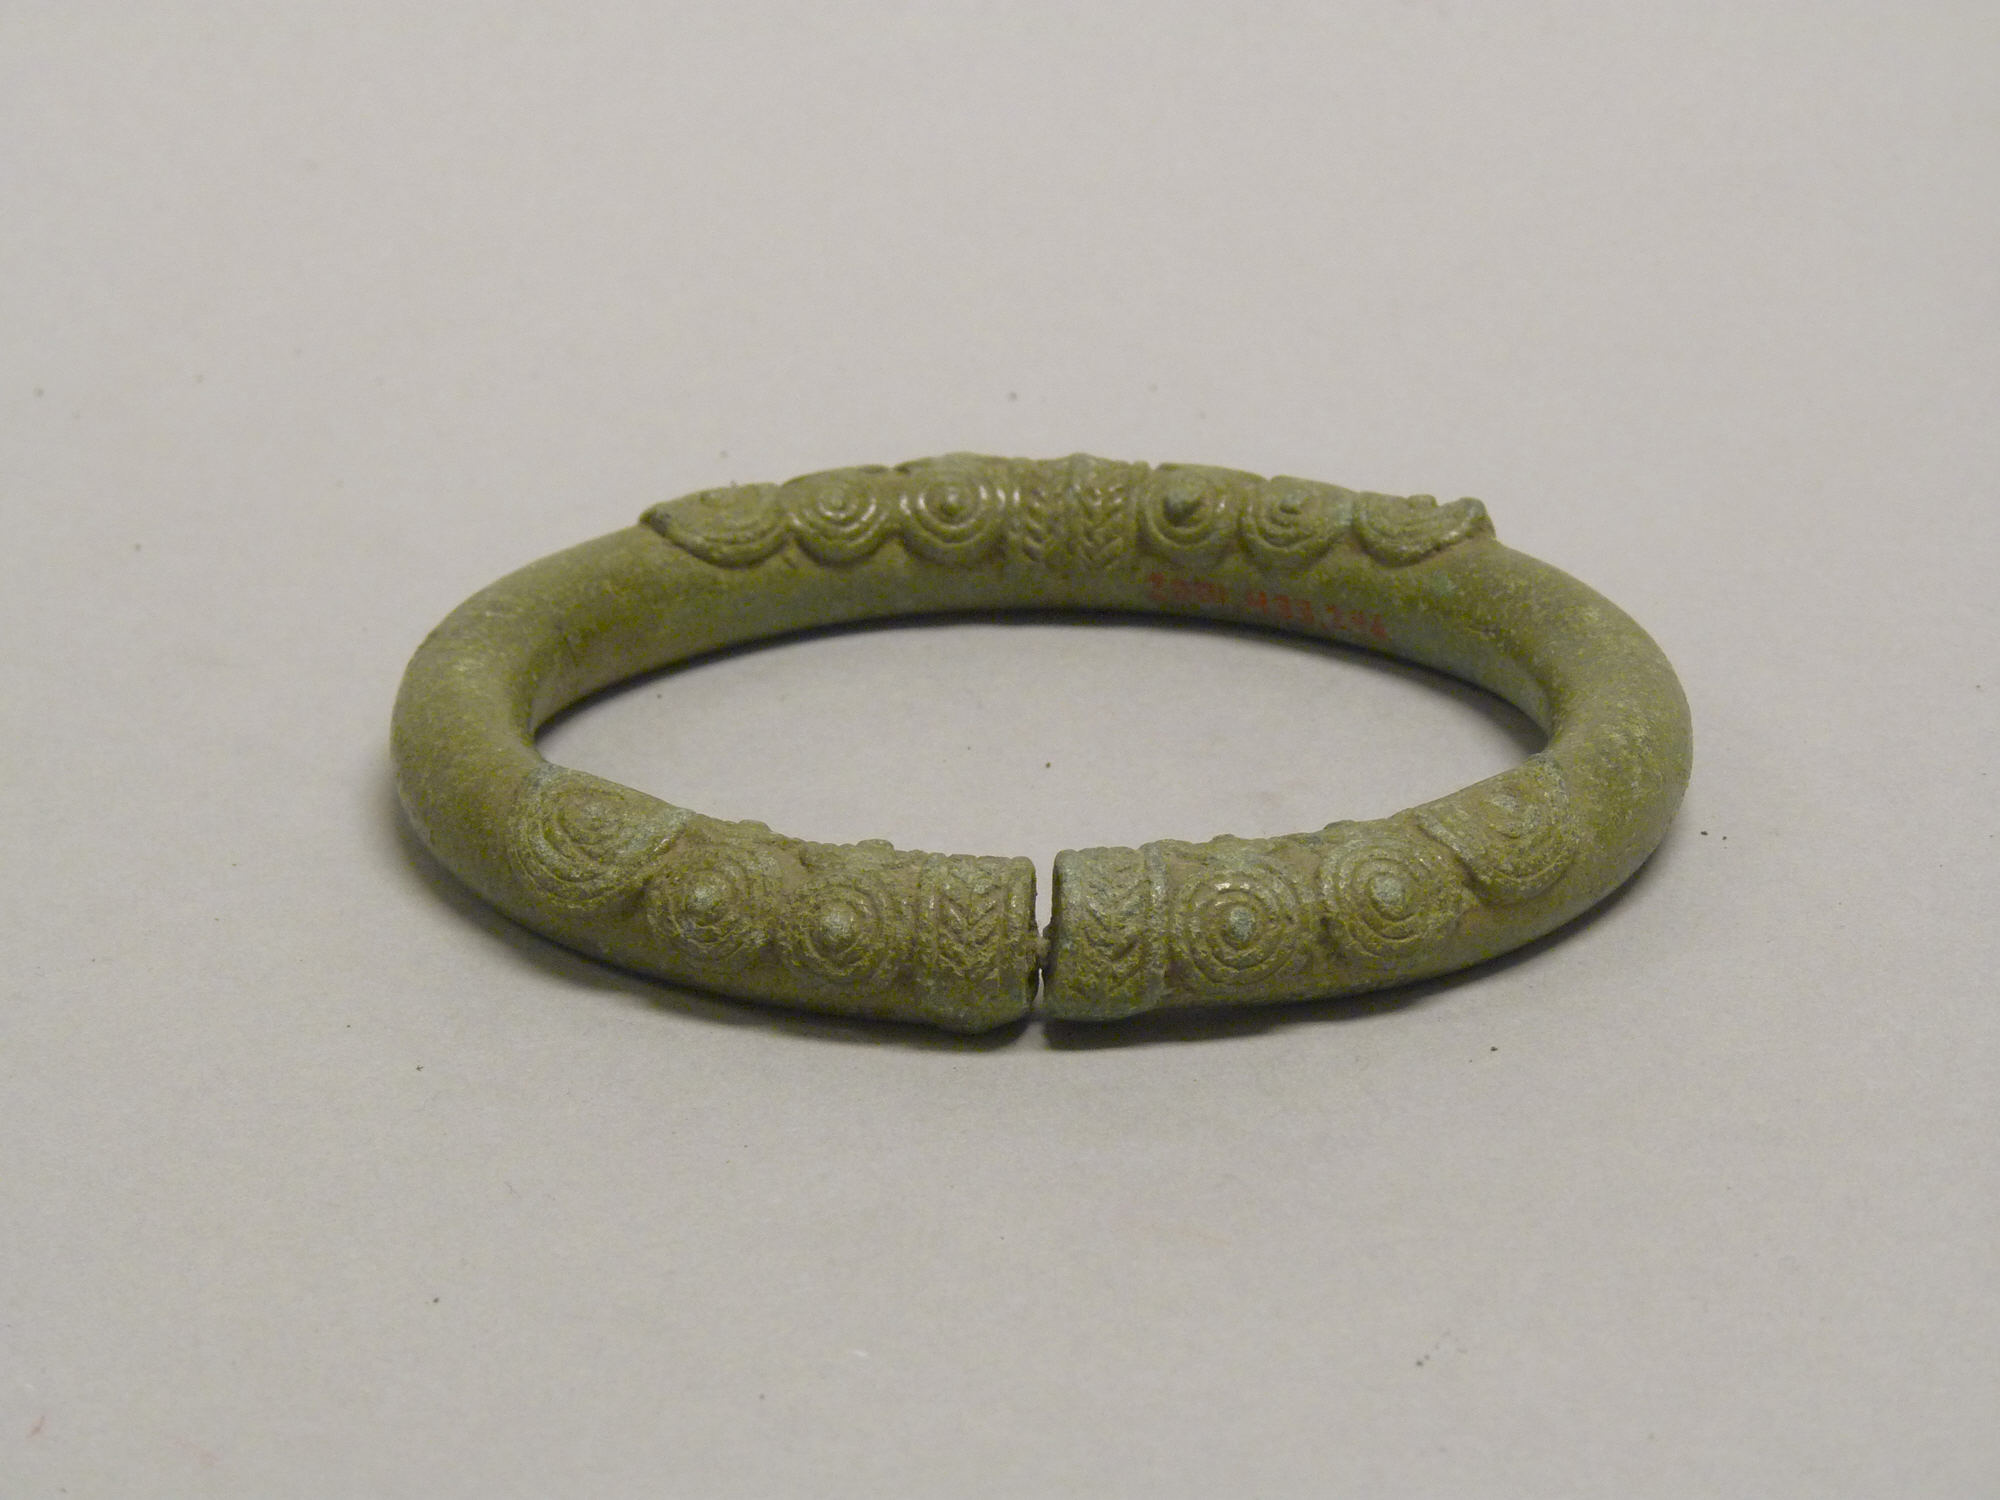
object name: anklet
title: One from a Pair of Solid Anklets with Spiral Decoration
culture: thai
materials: bronze